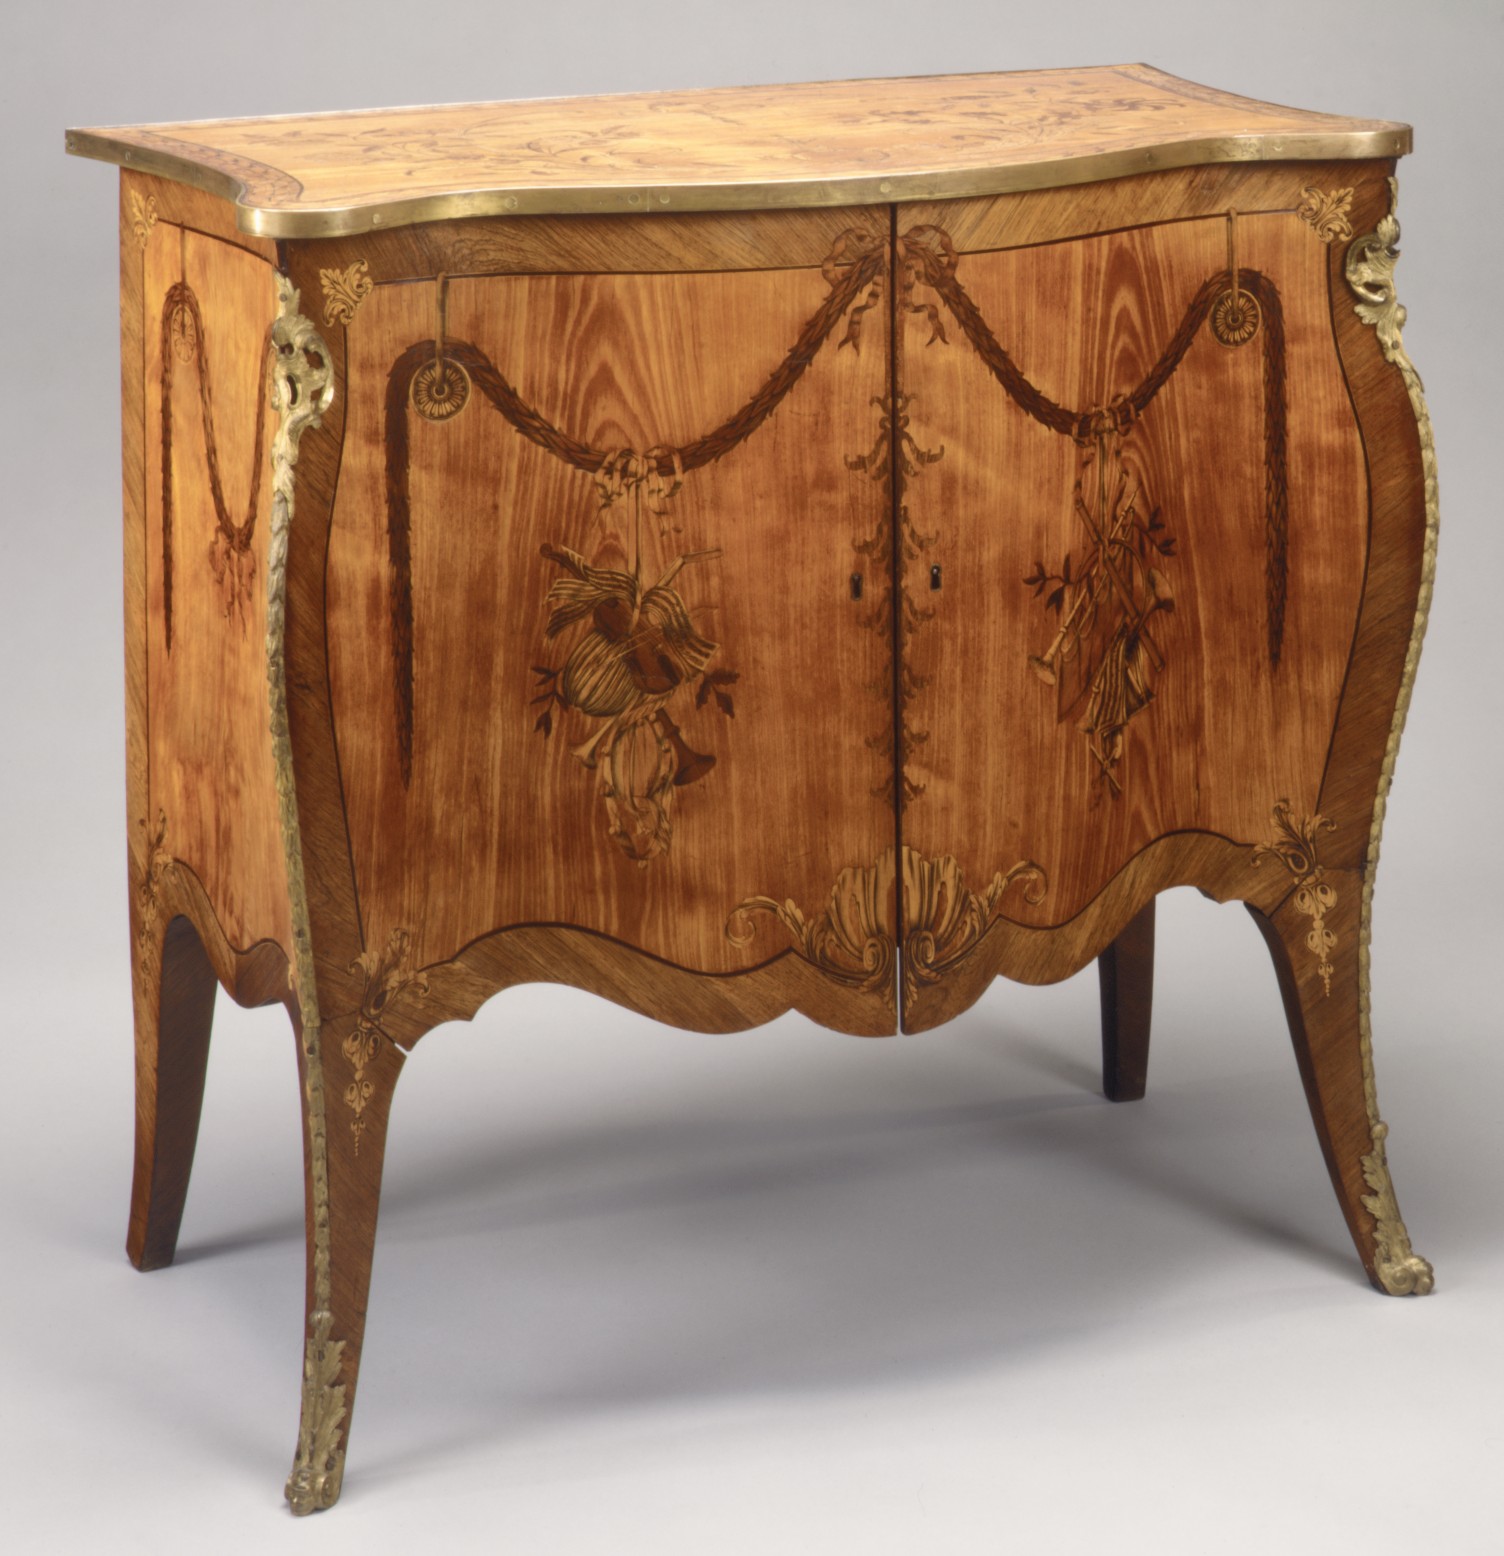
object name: commode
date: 1765-1770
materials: gilt, wood, metal